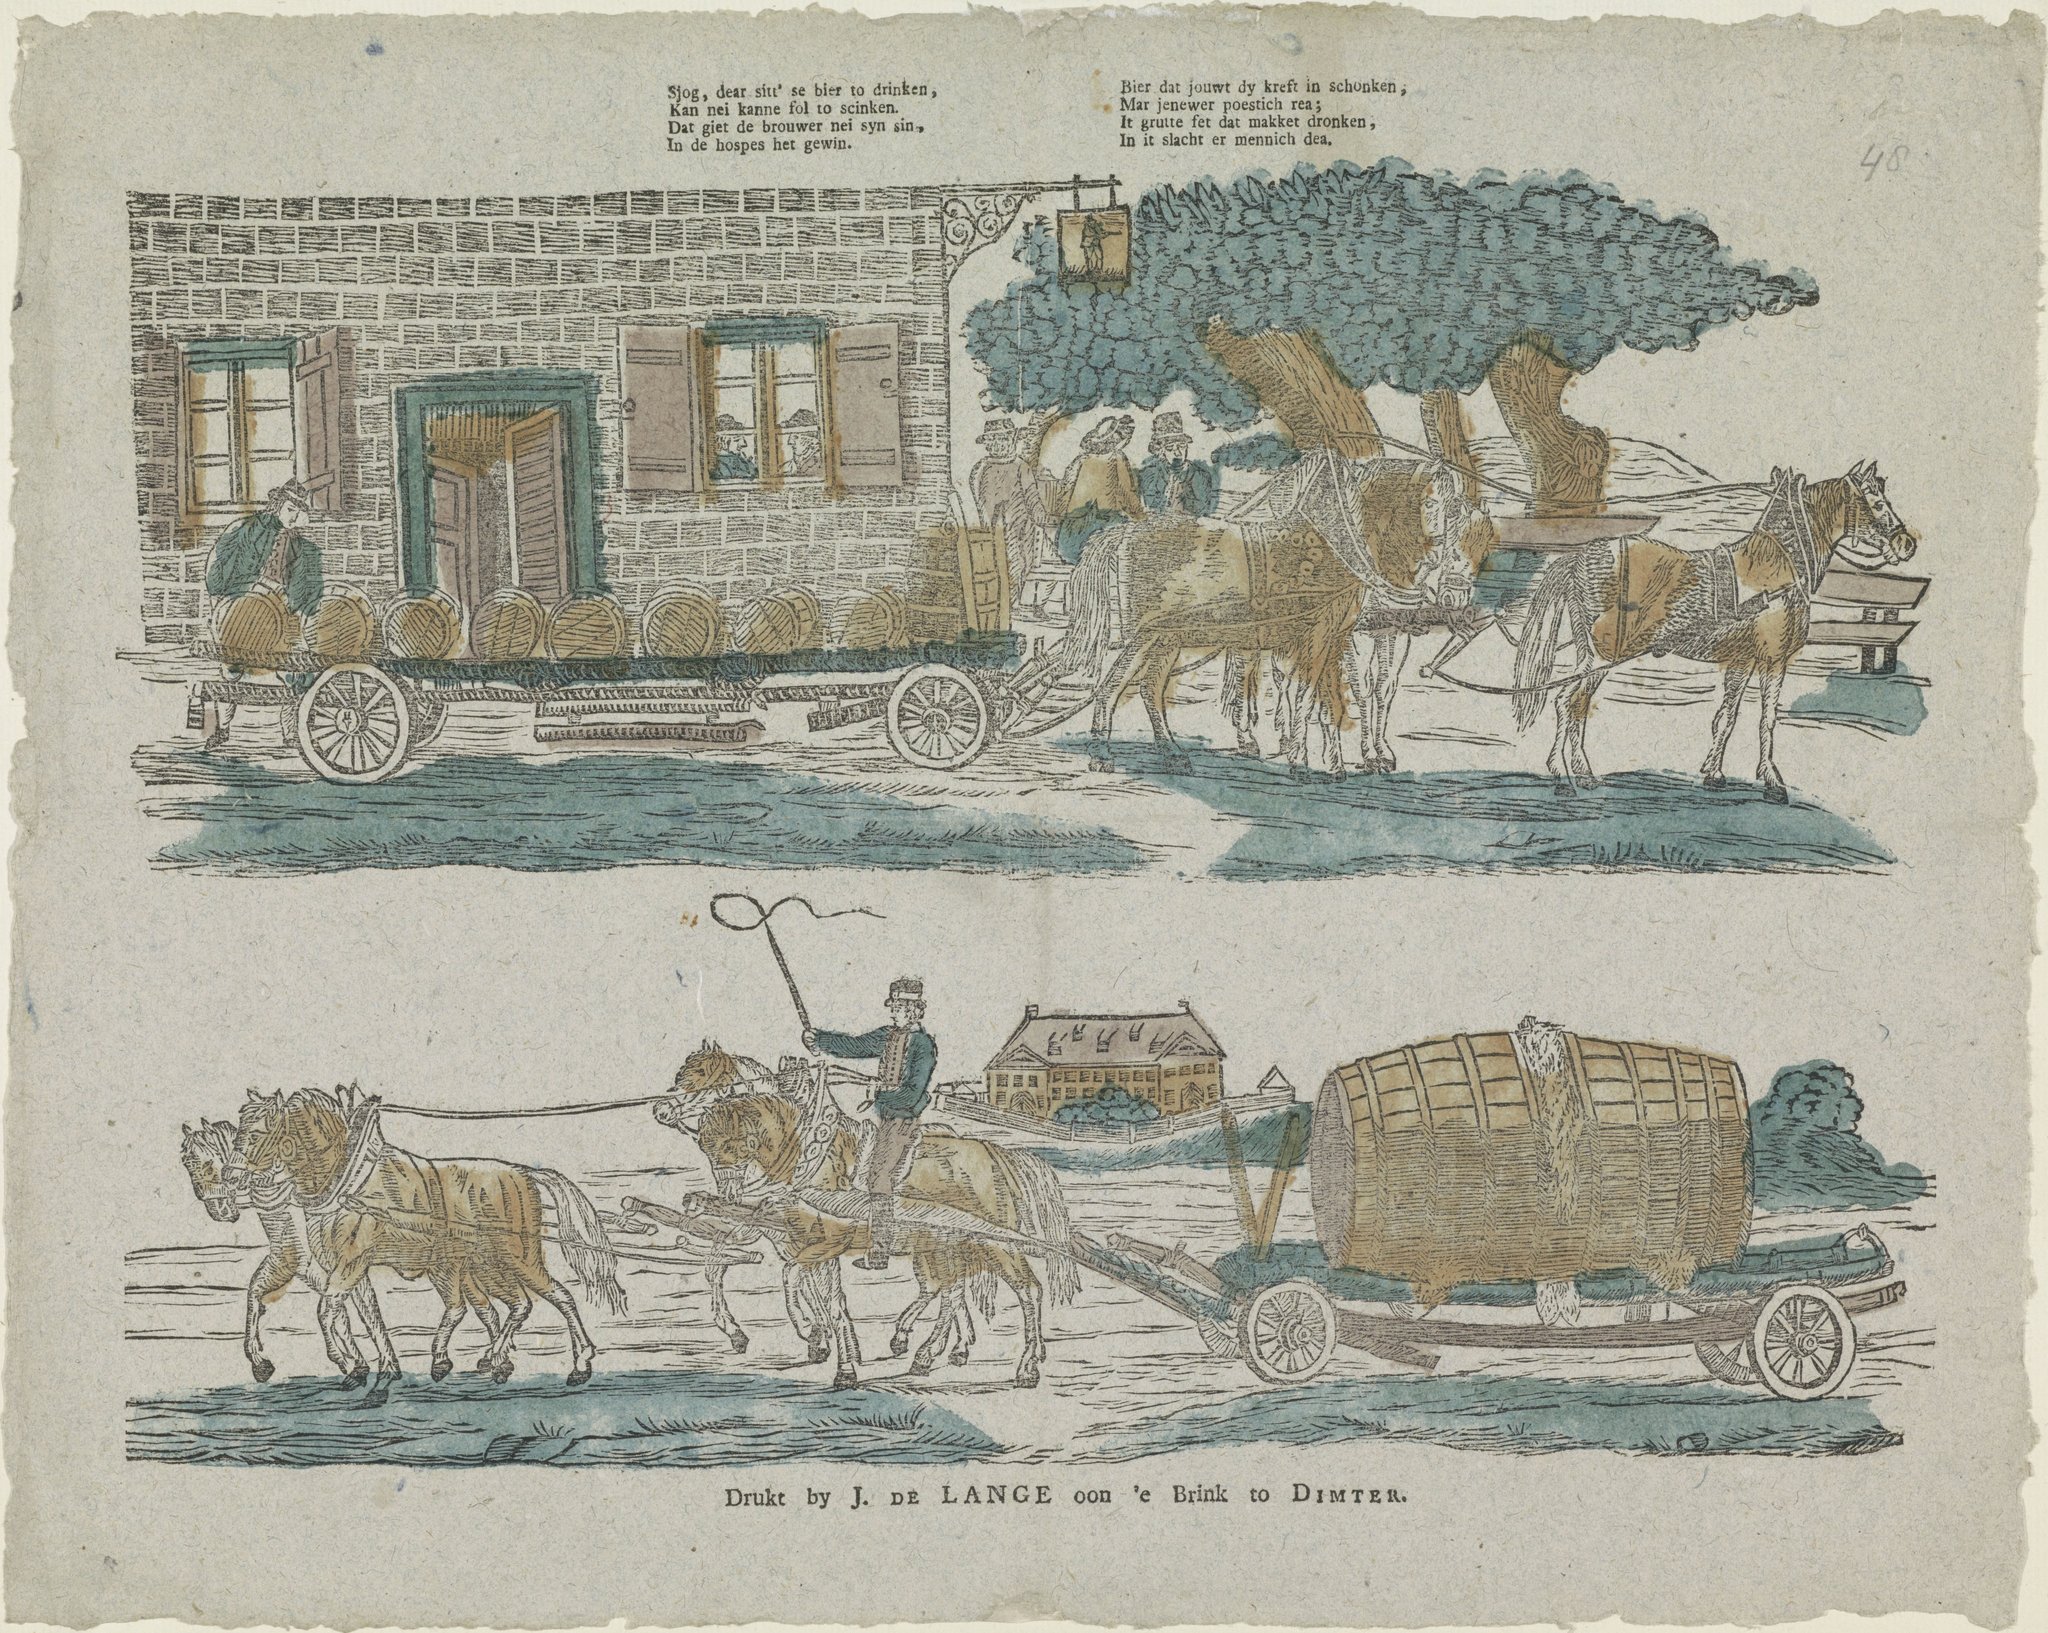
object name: print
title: Sjog, dear sitt'se bier to drinken, / Kan nei kanne fol to scinken [(...)]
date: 1822-1849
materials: paper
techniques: colour, letterpress printing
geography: netherlands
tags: traffic and transport, beer, ale (+ foodstuffs in other container, e.g.: barrel, can, cask, tin, etc.), hotel, hostelry, inn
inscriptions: collector's mark: Lugt 2760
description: Blad met 2 voorstellingen van bierwagens. Boven een achtregelig vers in het Fries.